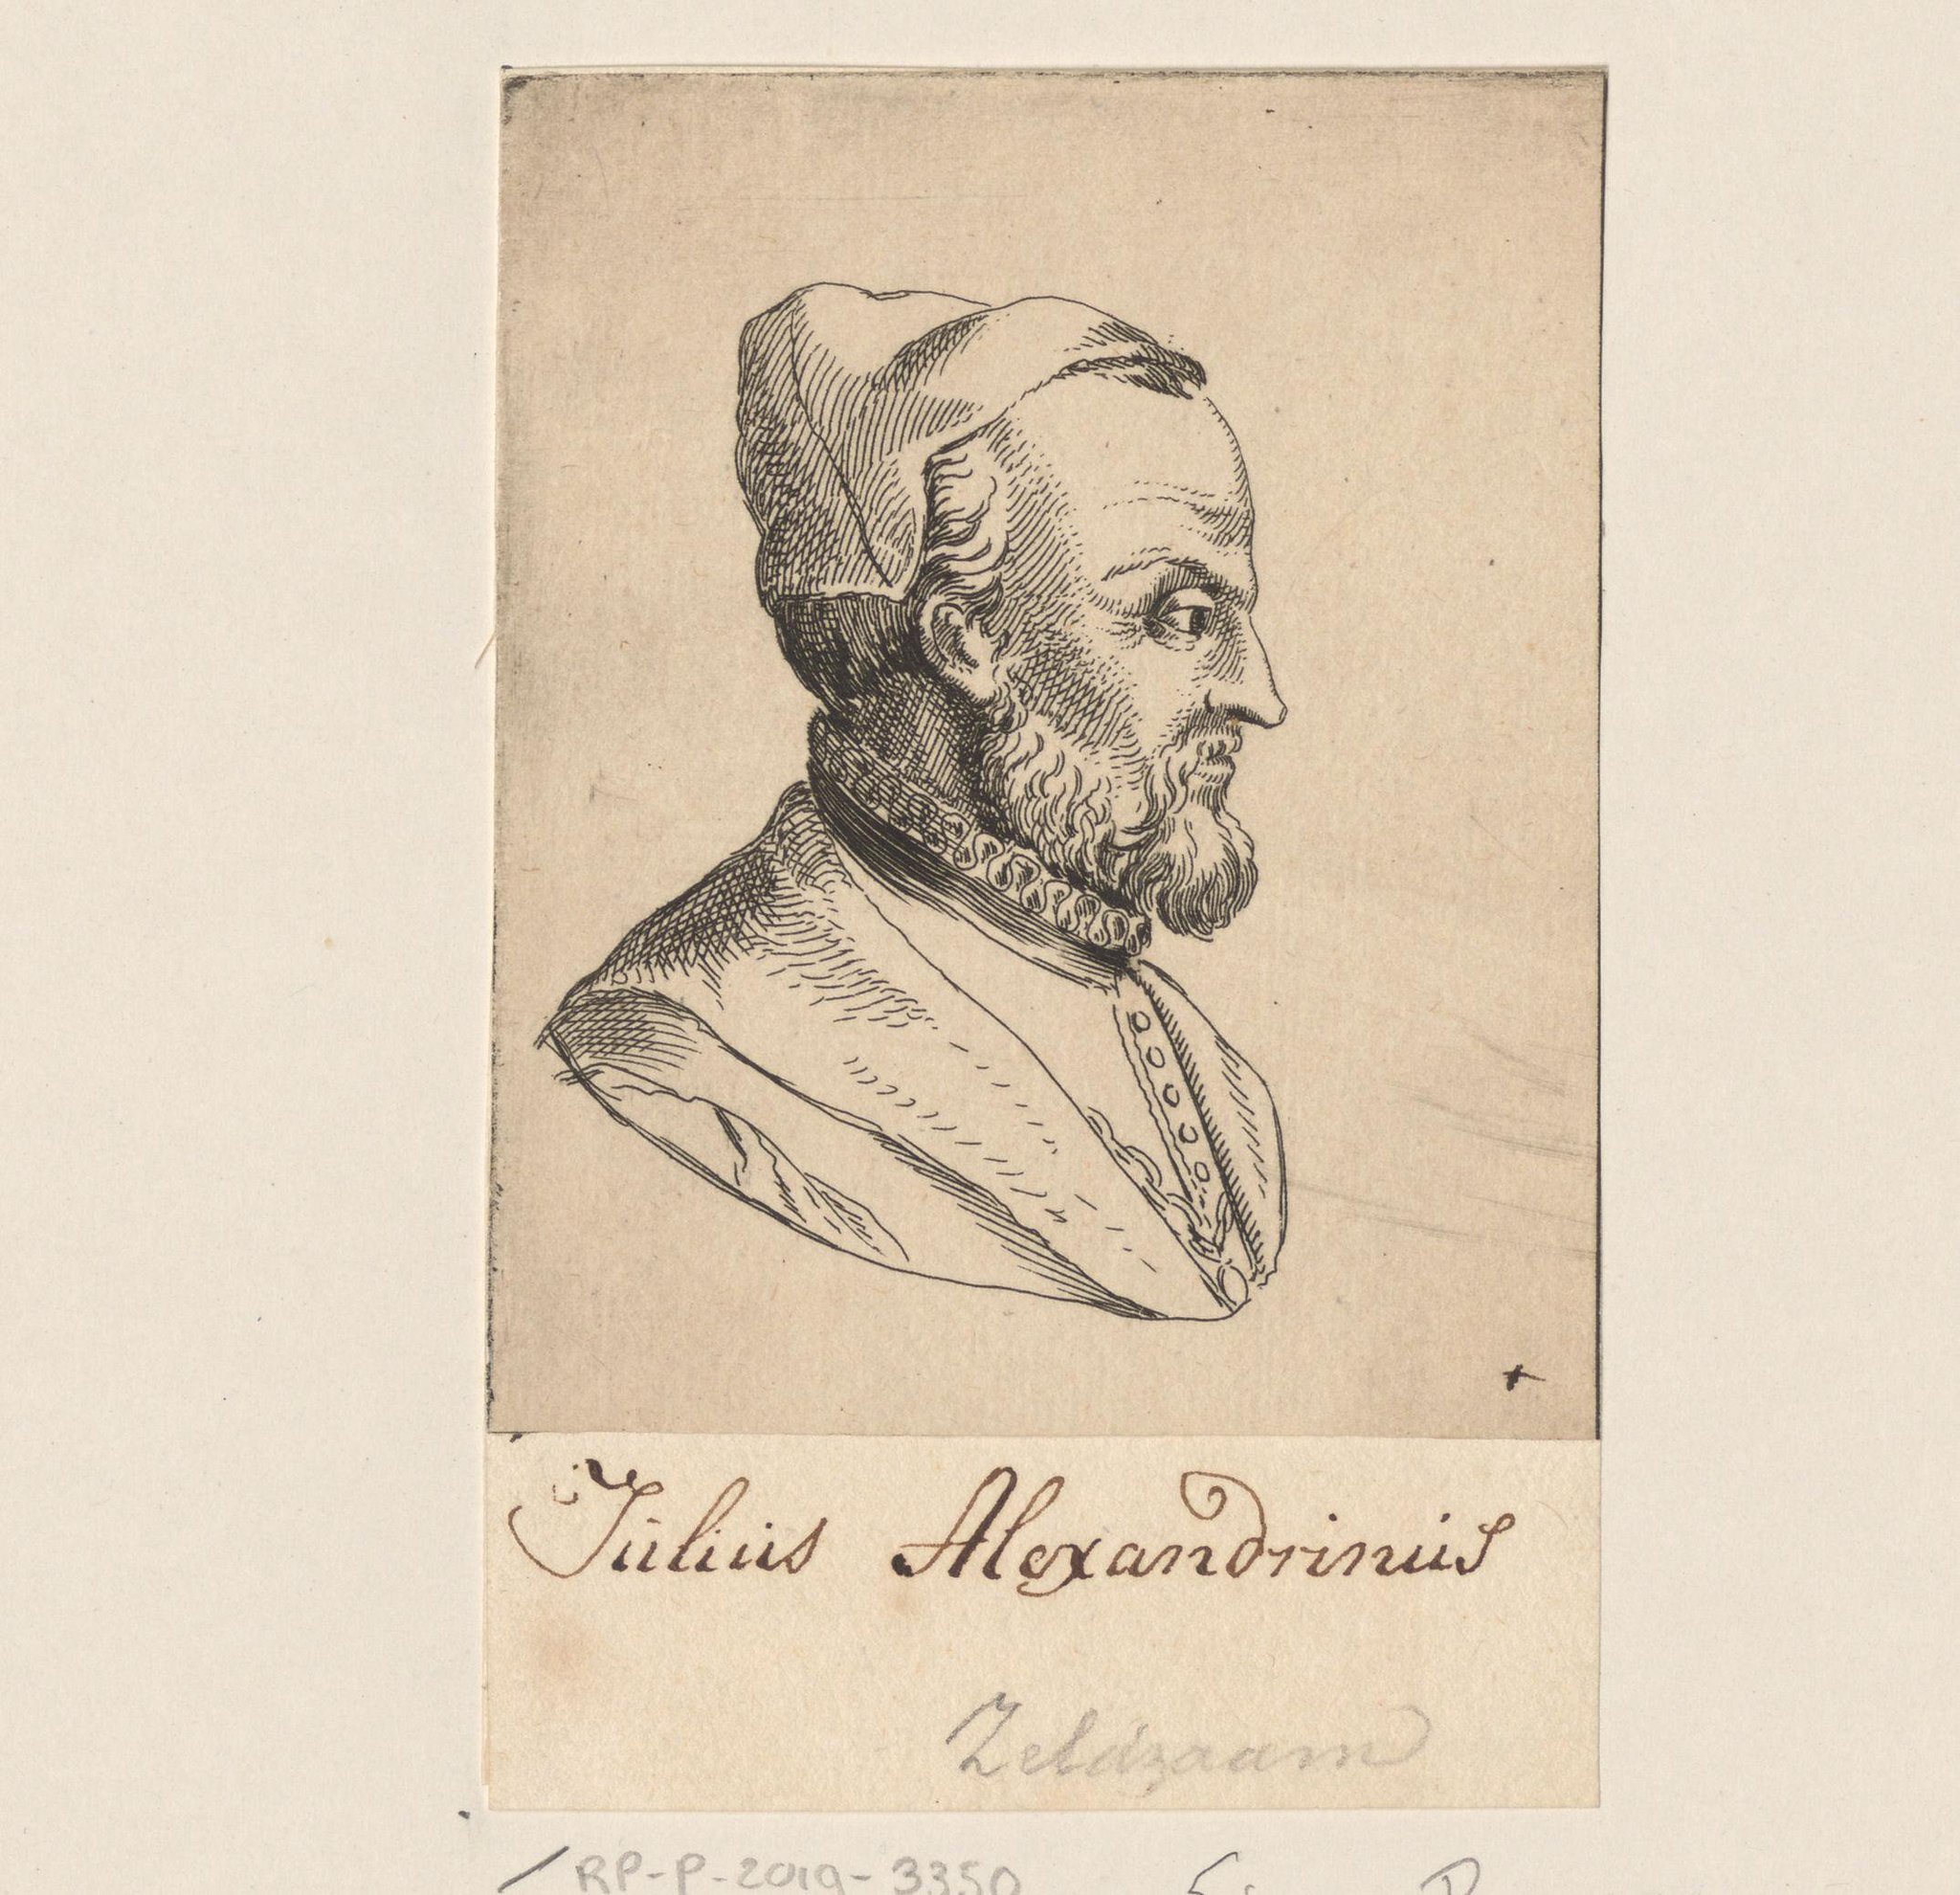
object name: print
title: Portret van Giulio Alessandrini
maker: Anonymous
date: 1600-1649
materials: paper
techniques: etching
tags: historical persons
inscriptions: inscription: ‘Julius Alexandrinus’